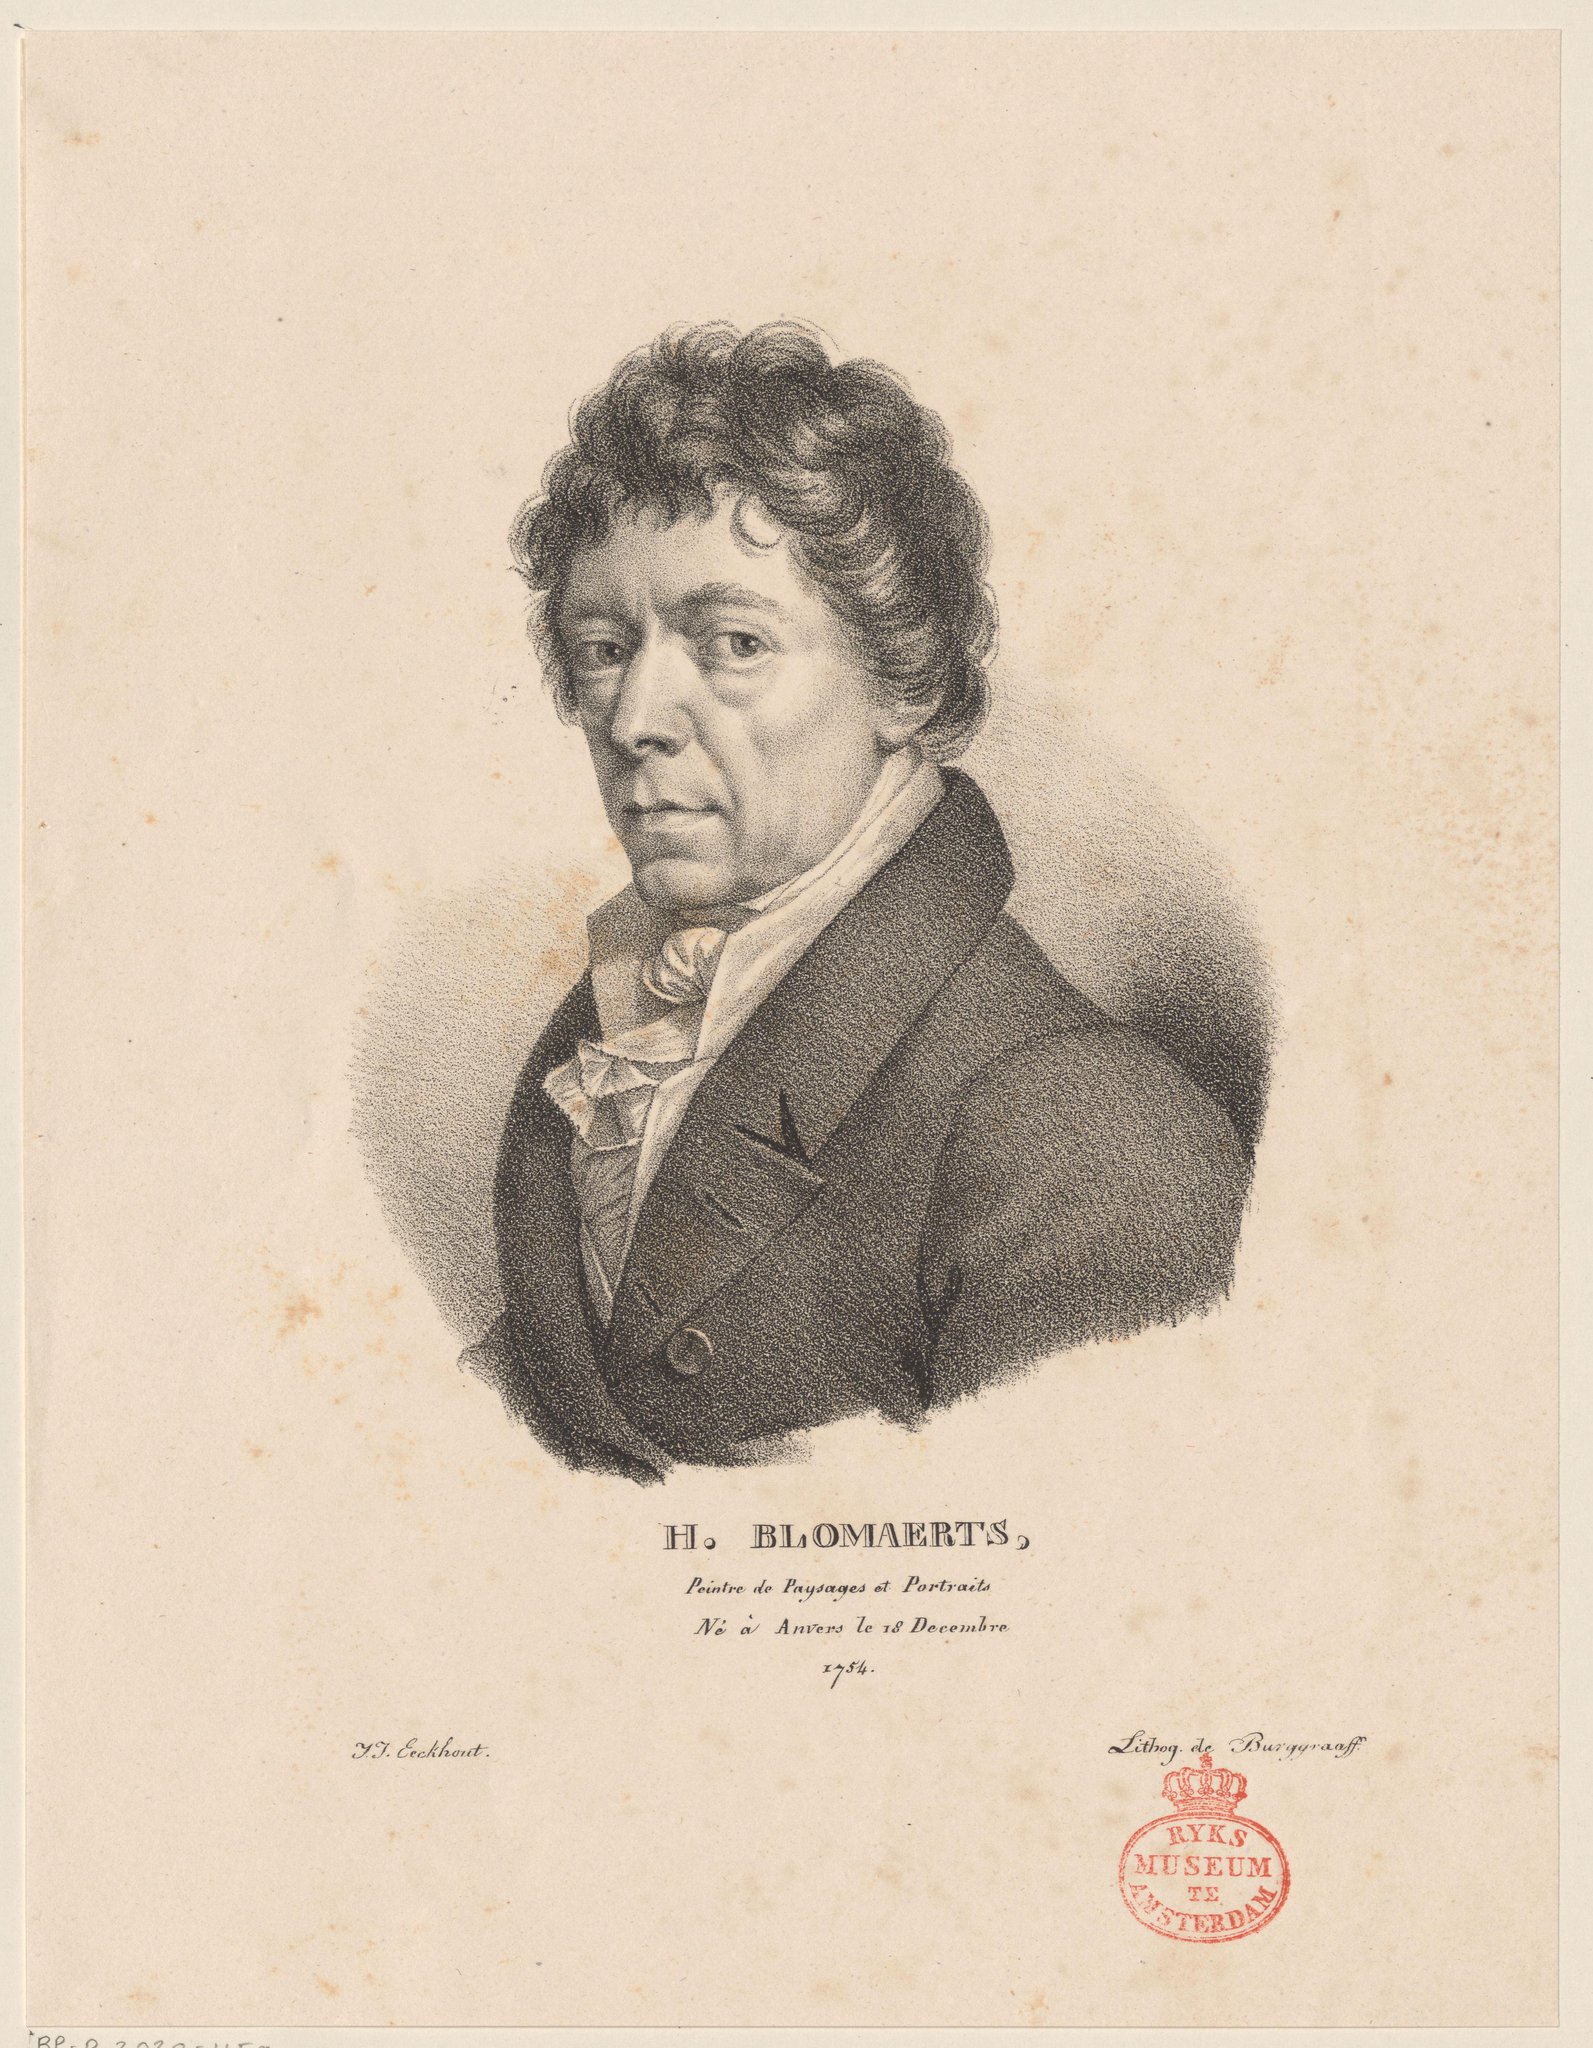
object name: print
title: H. Blomaerts, peintre de paysages et portraits (...)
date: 1822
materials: paper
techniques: lithograph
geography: brussels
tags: antwerp, brussels, painter, artist, historical persons, portrait, self-portrait of painter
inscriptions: collector's mark: Lugt 12